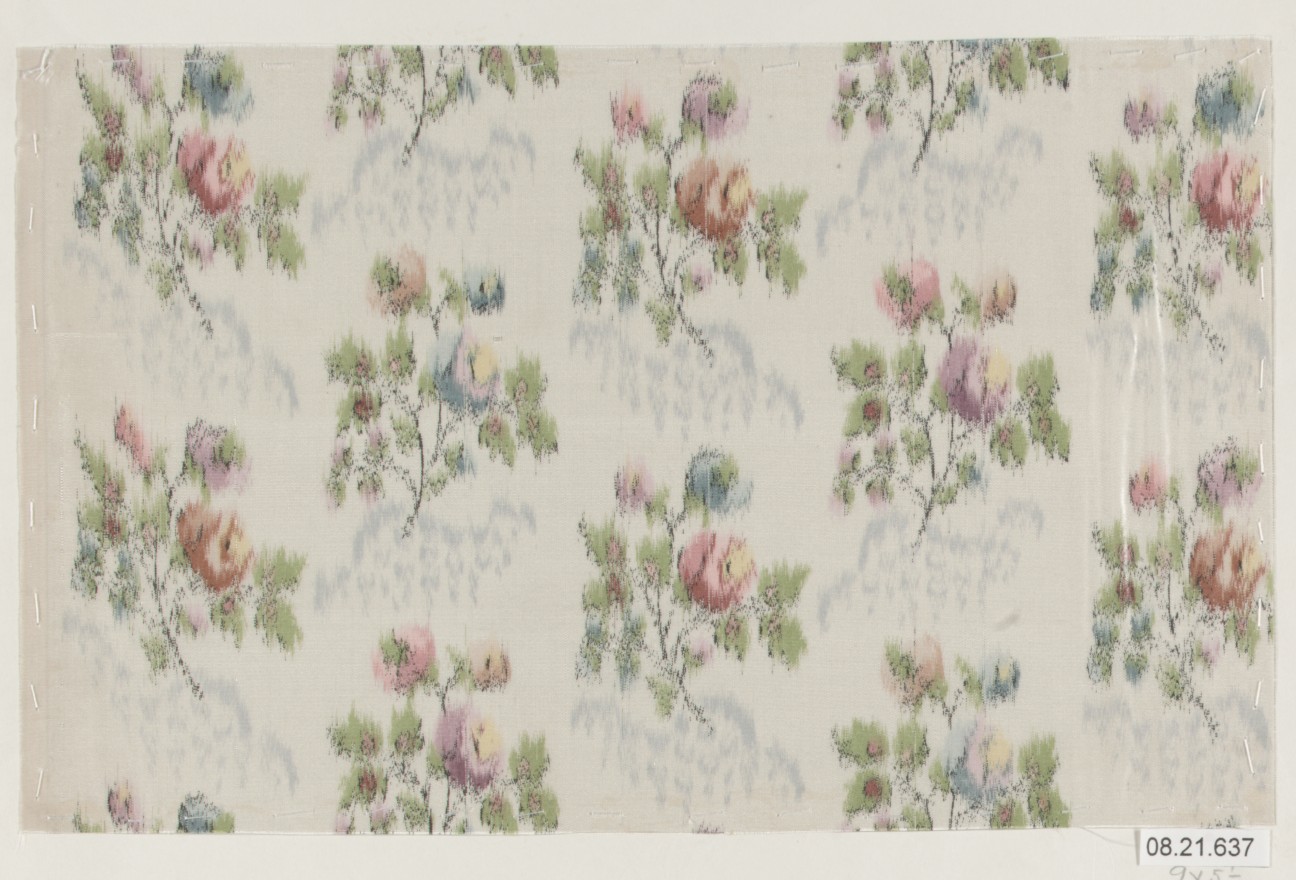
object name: textile sample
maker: Anonymous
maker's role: designer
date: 1900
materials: silk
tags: flowers